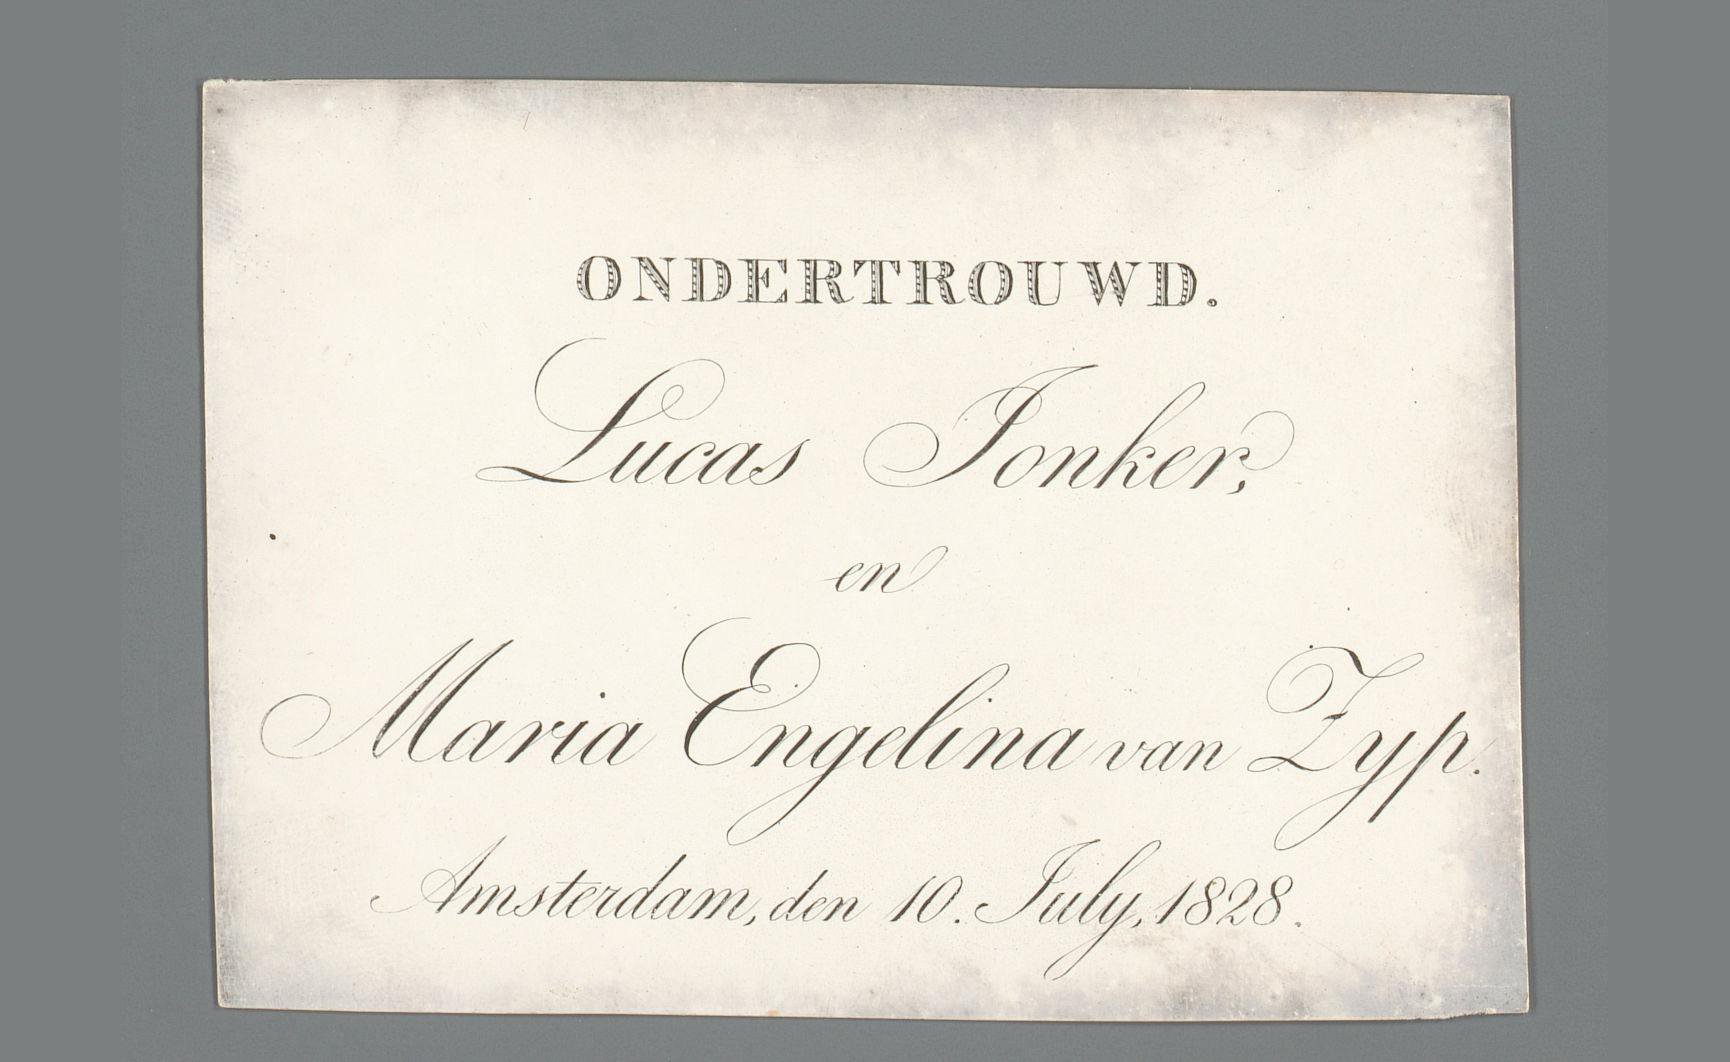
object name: wedding announcement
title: Aankondiging van ondertrouw van Lucas Jonker en Maria Engelina van Zijp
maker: Anonymous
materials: paper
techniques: printing block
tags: fancy letters, betrothal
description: Typografische kaart, met de tekst: 'Ondertrouwd. Lucas Jonker, en Maria Engelina van Zijp. Amsterdam, den 10. July, 1828'.